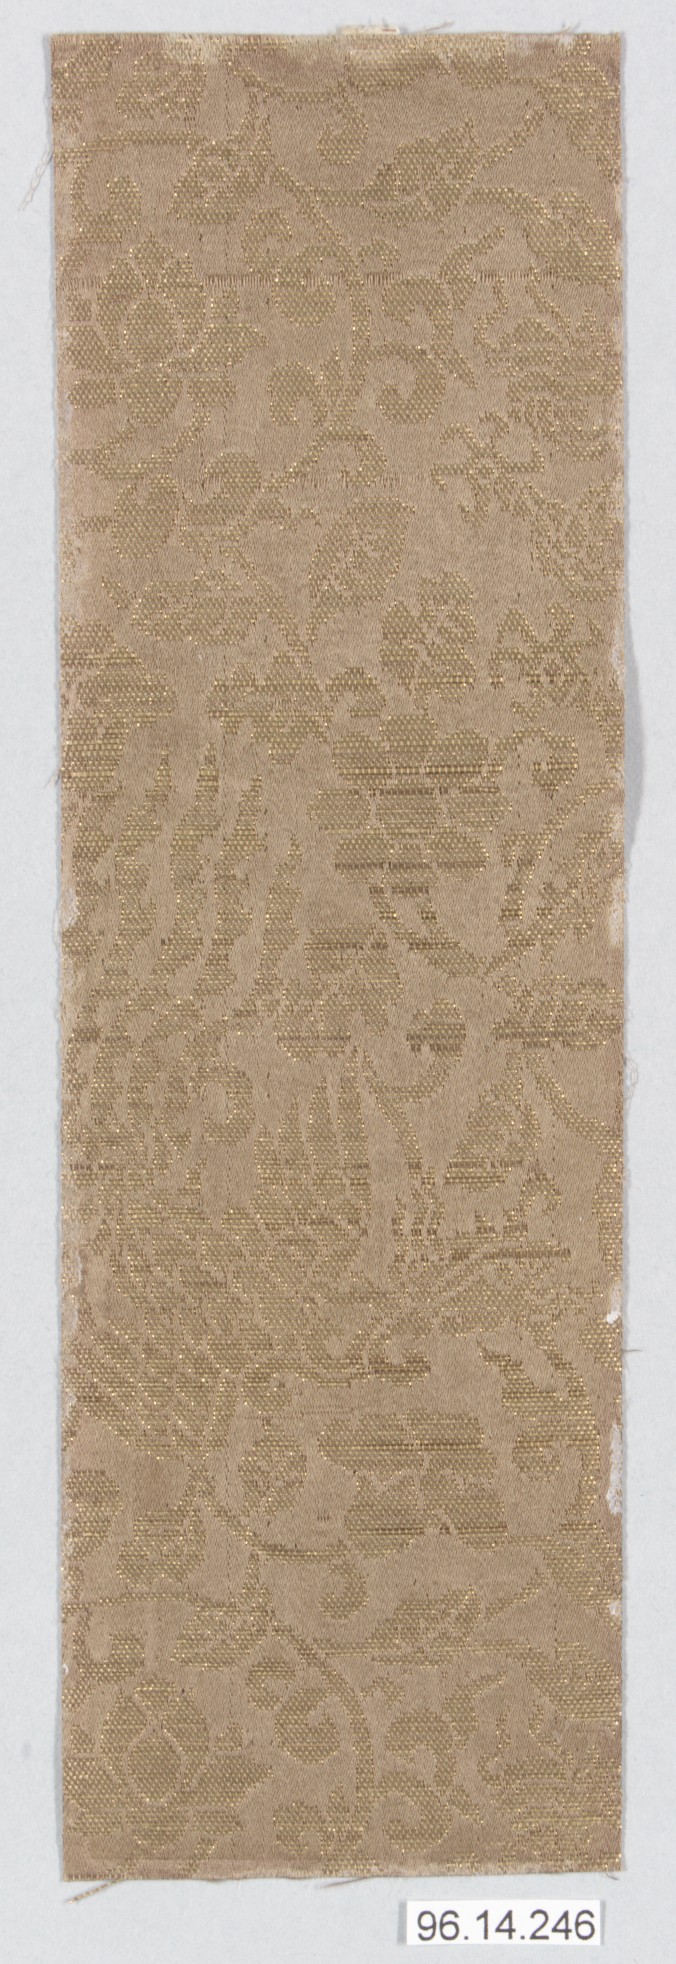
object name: piece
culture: japanese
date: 1701-1900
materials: silk